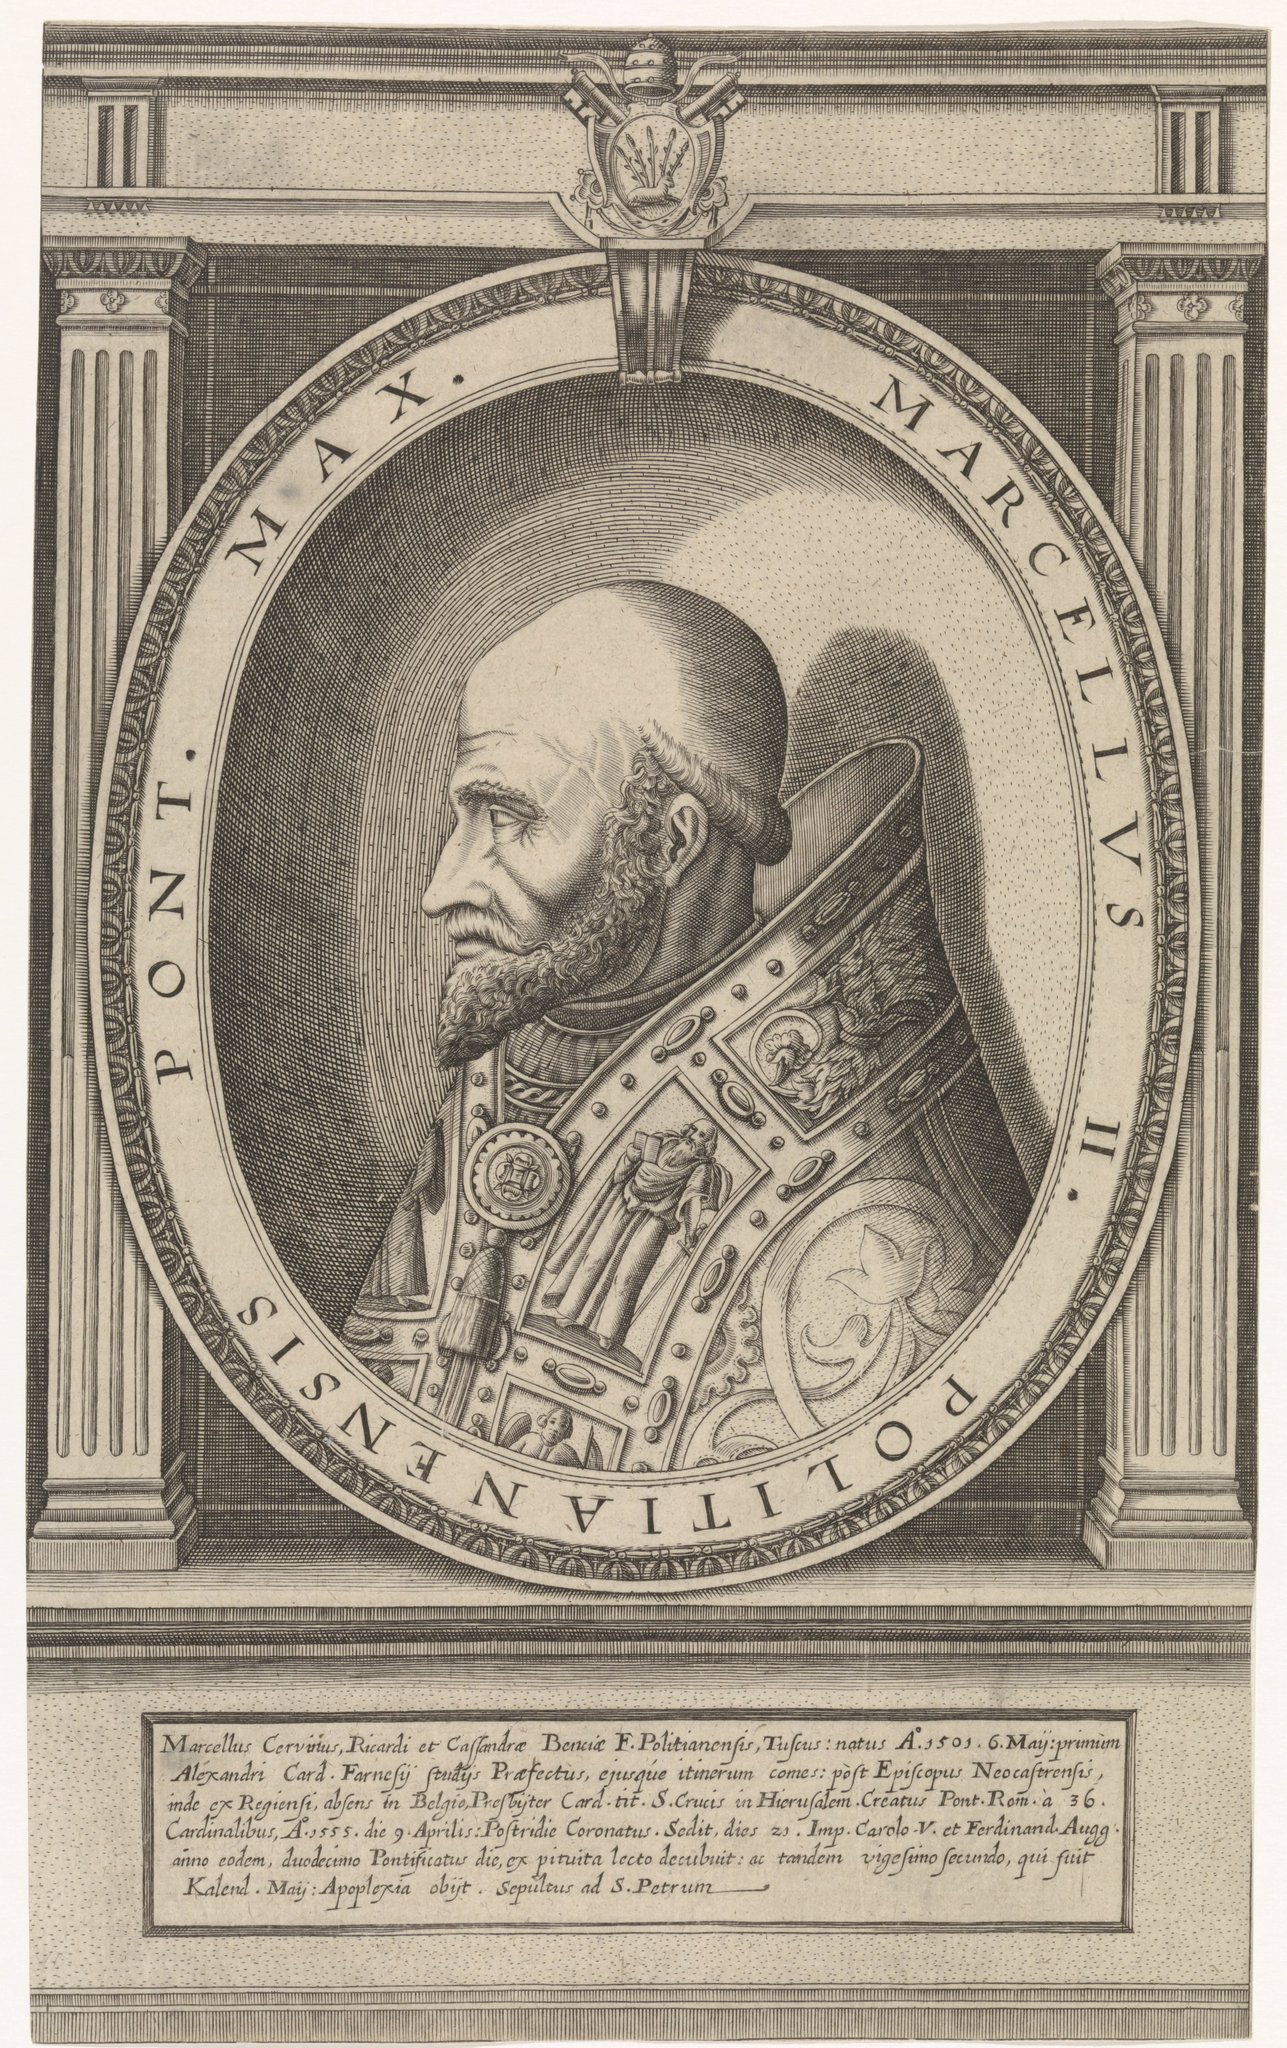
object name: print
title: Portret van paus Marcellus II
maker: friedrich van hulsen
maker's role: print maker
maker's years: 1580-1660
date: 1590-1665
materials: paper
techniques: engraving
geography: germany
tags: rome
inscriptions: collector's mark: Lugt 2228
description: Portret van paus Marcellus II gehuld in het pauselijk gewaad. Buste en profil naar links in een ovale lijst met randschrift. Midden boven is zijn pauselijk wapen afgebeeld. Onder het portret zes tekstregels in het Latijn.